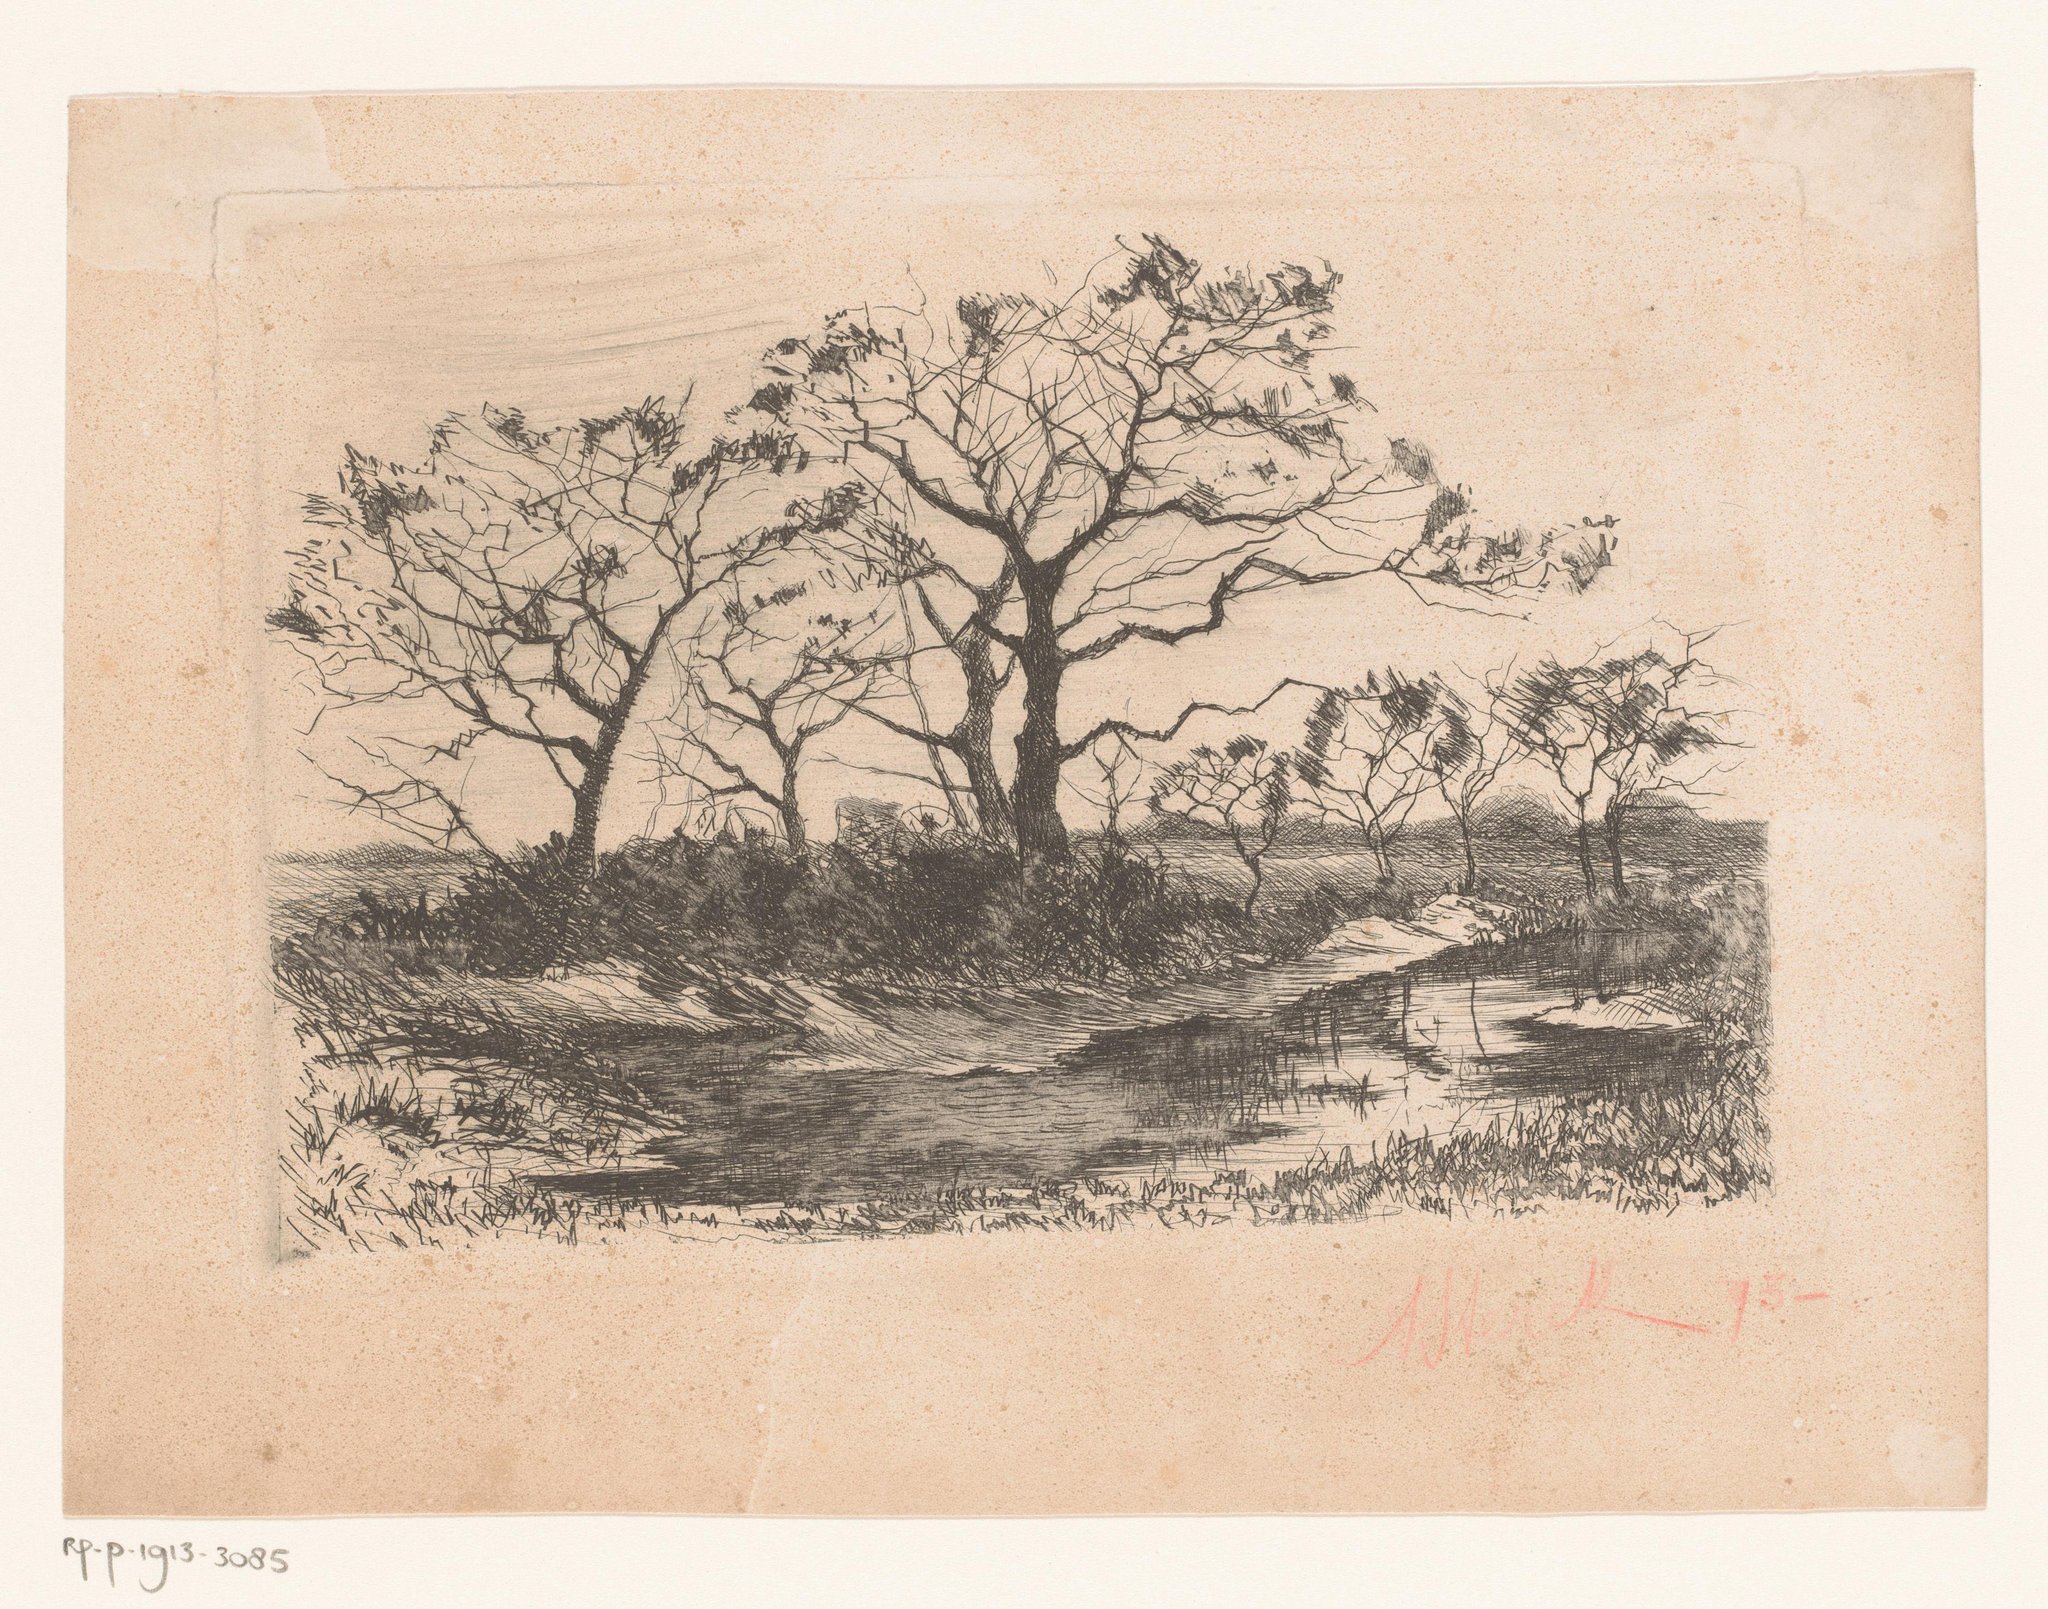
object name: print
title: Heidelandschap met kale bomen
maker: arthur sterck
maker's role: print maker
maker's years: 1868-1897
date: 1893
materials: paper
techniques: drypoint, etching, intaglio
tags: plain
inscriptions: collector's mark: Lugt 2228